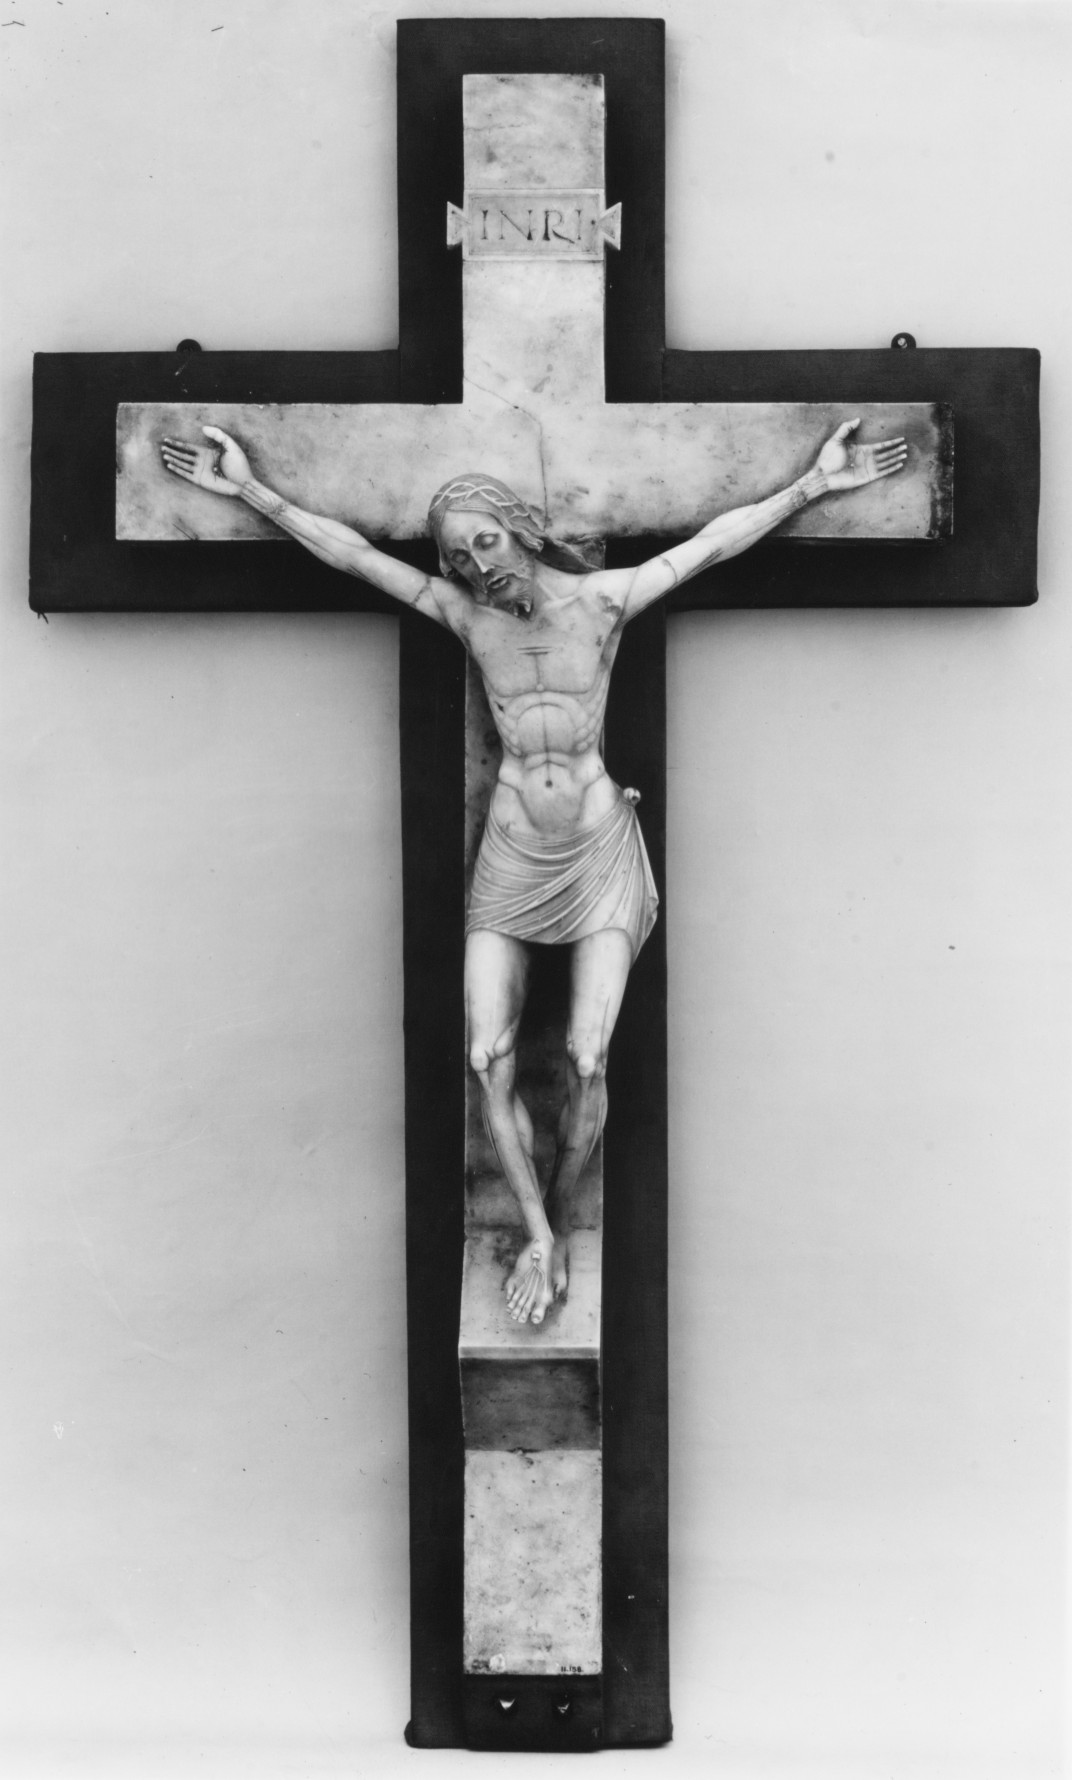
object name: crucifix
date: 1467-1533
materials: marble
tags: cross,jesus,crucifixion